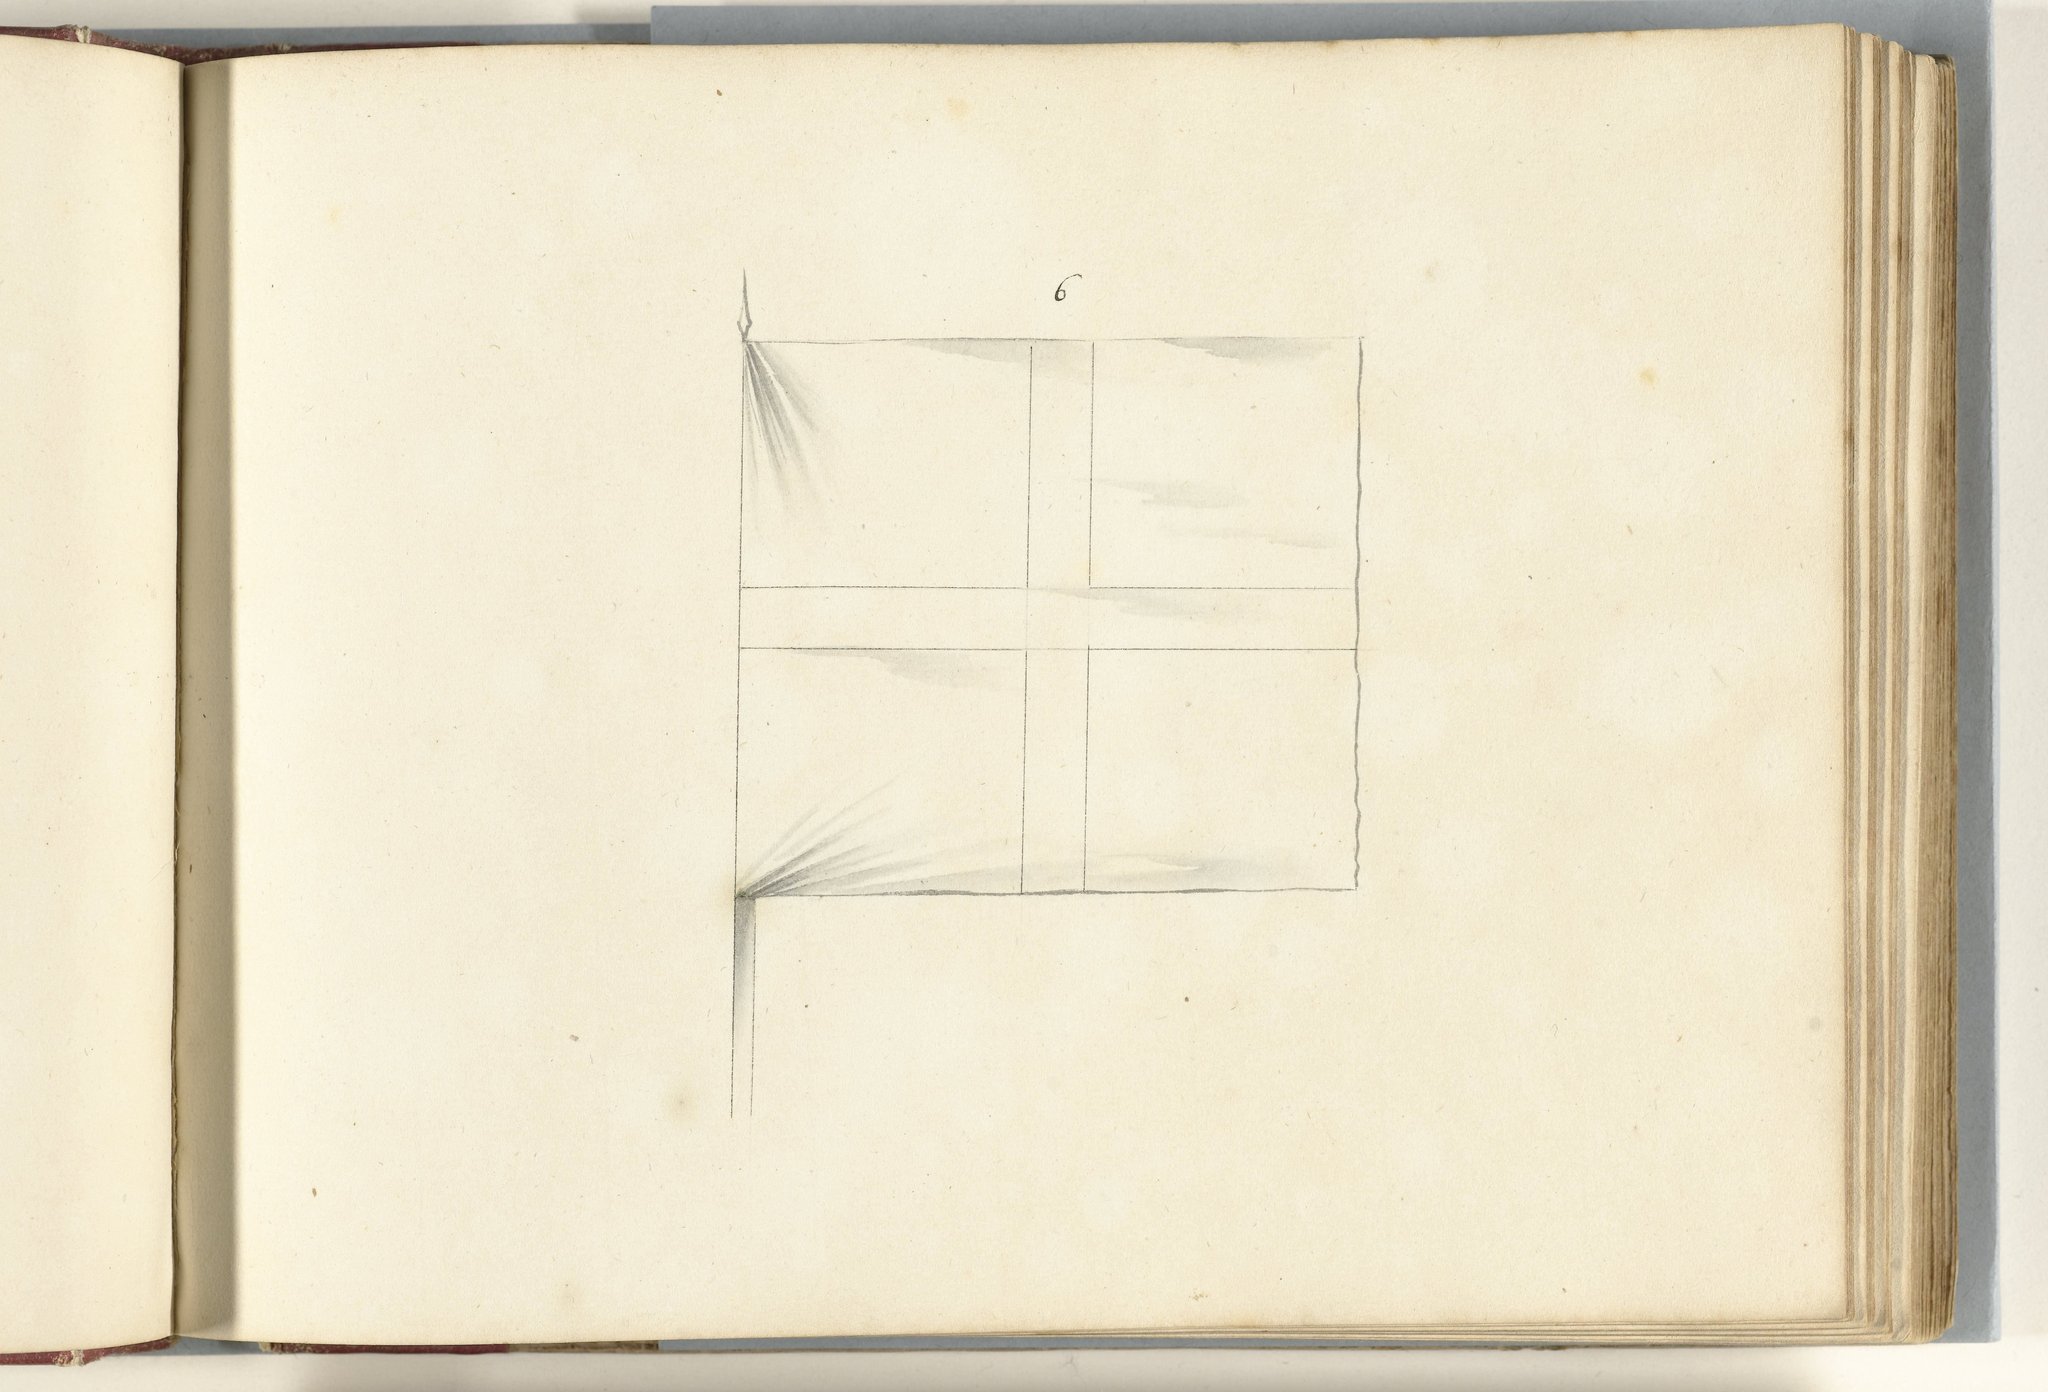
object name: drawing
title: Frans vaandel veroverd bij de slag bij Ramillies, 1706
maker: Anonymous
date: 1713-1720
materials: paper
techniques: drawing, writing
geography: northern netherlands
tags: (military) flags and standards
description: Frans vaandel veroverd bij de slag bij Ramillies 1706. In het boek met tekeningen van Franse vaandels, standaarden en pauken, veroverd tijdens de Spaanse Successieoorlog (1701-1713).